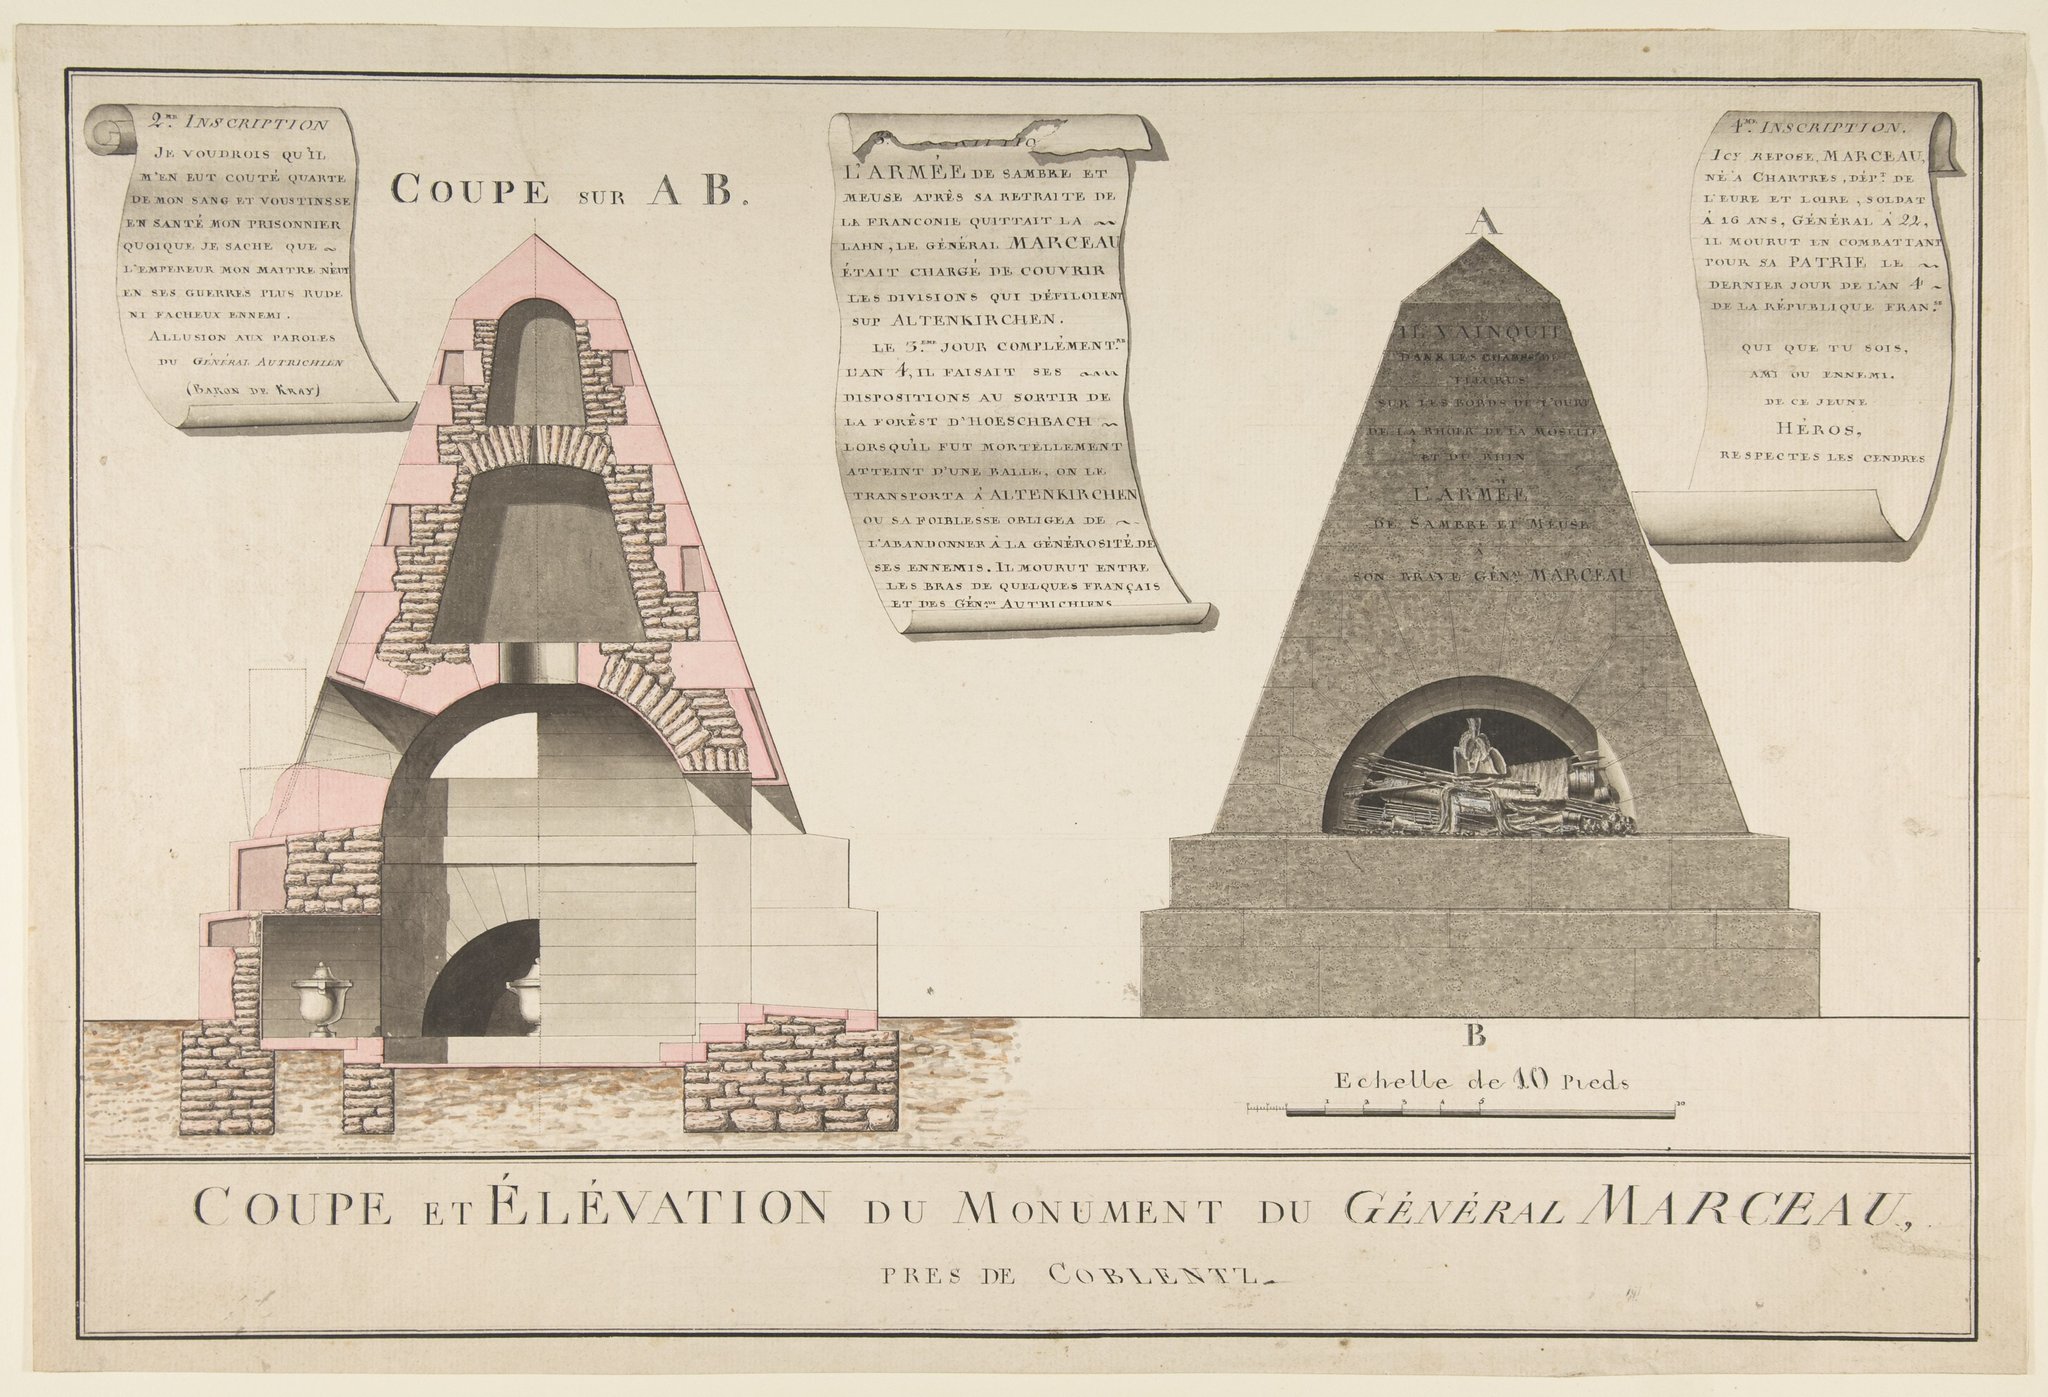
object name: drawing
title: Cross-Section and Elevation of the Funeral Monument for General François Séverin Marceau (1769–1796)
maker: anonymous, french, 18th century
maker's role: artist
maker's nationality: french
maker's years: 1700-1800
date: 1801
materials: ink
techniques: brush, heightening, pen, wash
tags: architecture,monuments